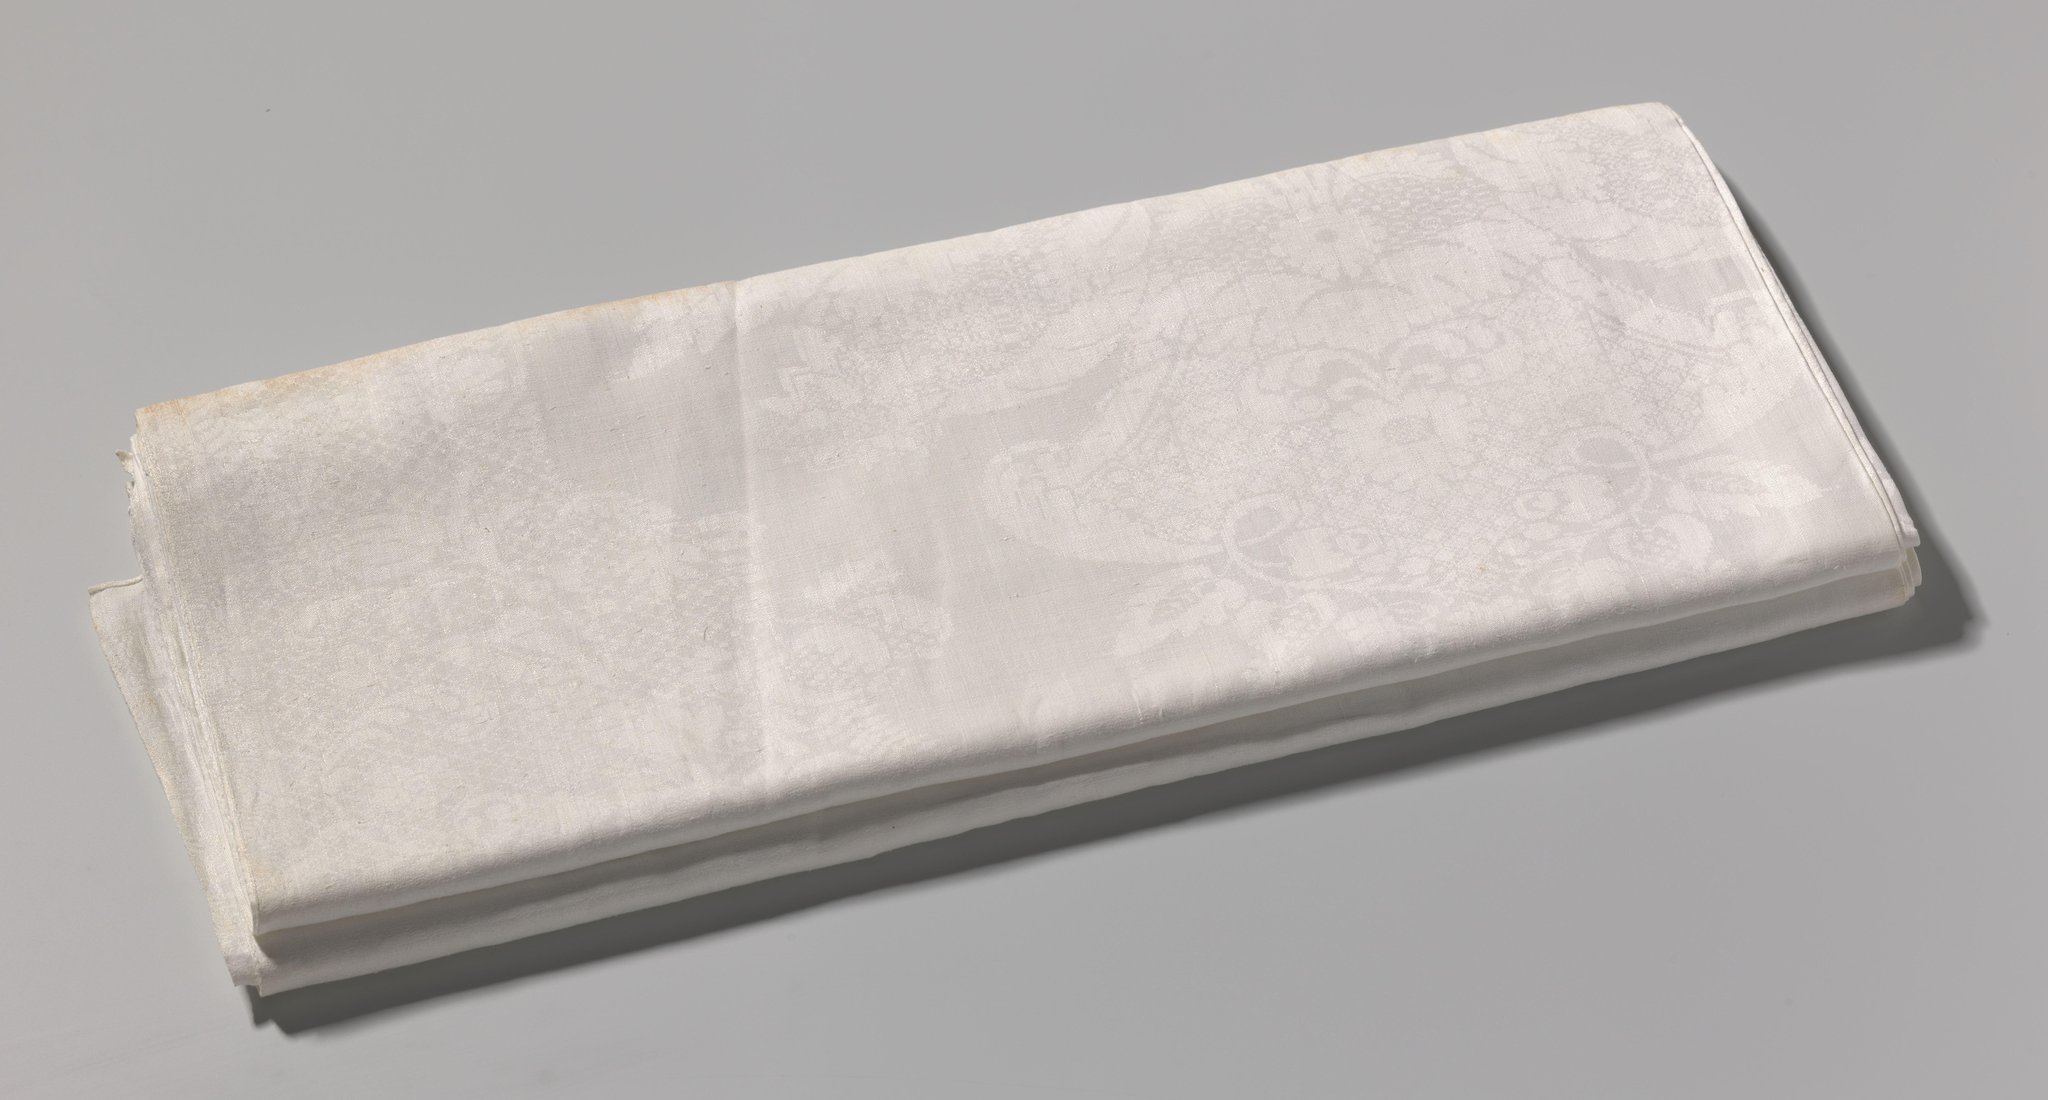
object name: tablecloth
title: Tafellaken van linnendamast met een kantpatroon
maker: Anonymous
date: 1650-1700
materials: linen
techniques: damask, weave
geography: flanders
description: Tafellaken van linnendamast met bloemen- met kantpatroon. Bij het tafellaken horen twee servetten (BK-1977-295-A en BK-1977-295-B).